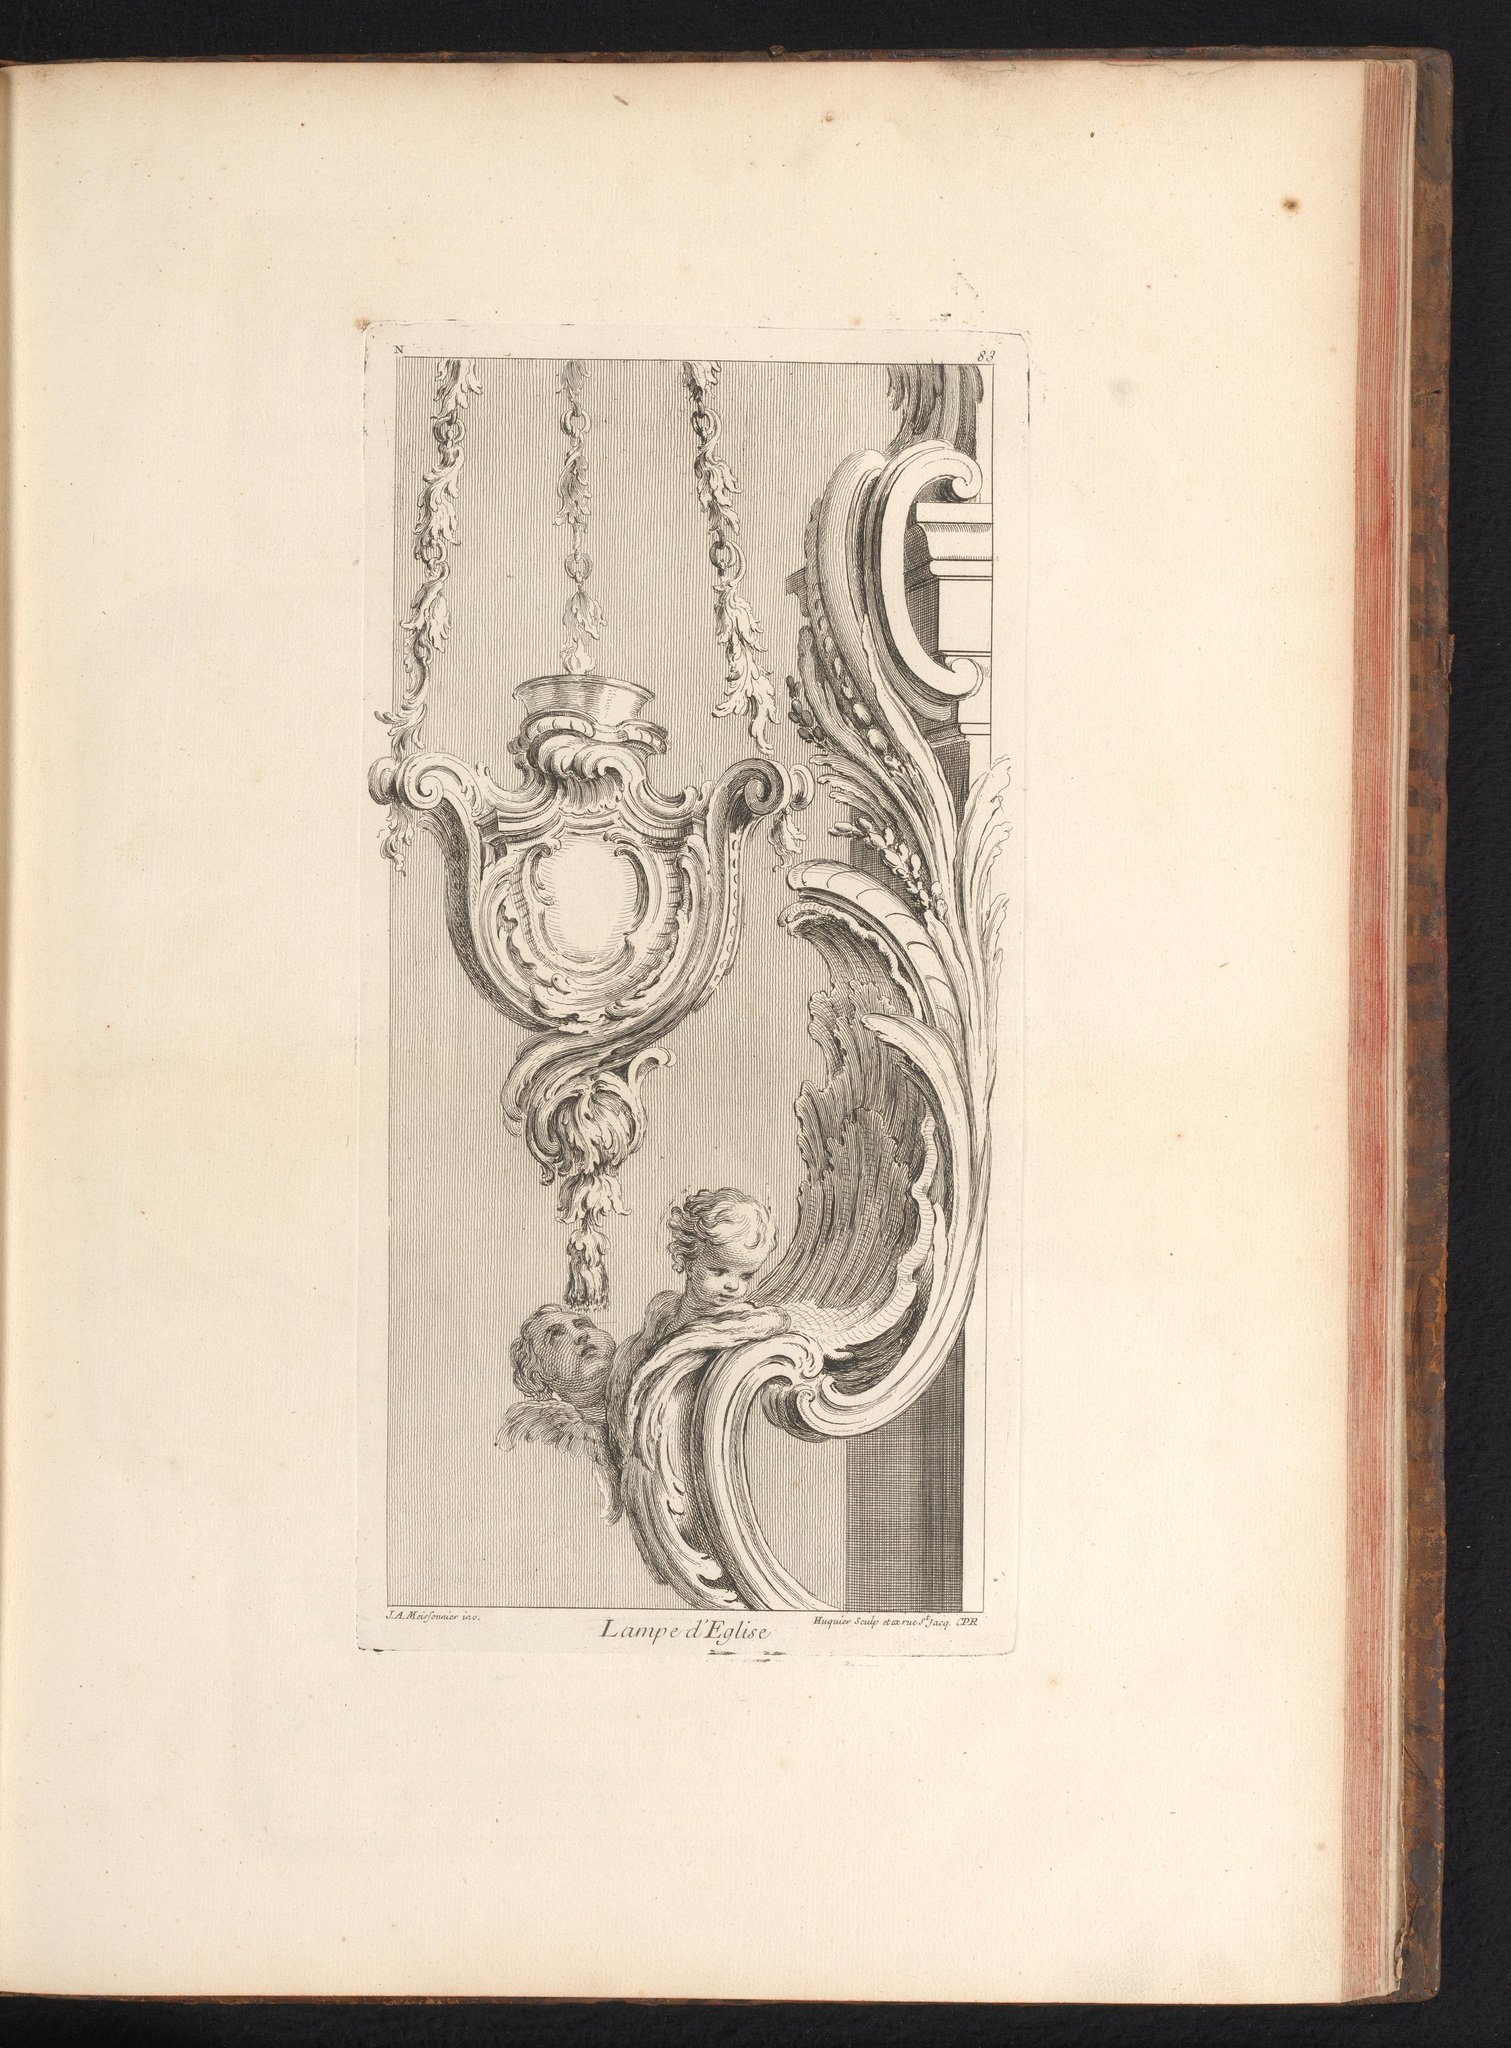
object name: ornament print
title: Lampe d'eglise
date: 1738-1749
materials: paper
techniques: etching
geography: paris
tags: other objects ~ the church (not necessarily liturgical, oil-lamp, work of applied art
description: Deze prent maakt deel uit van de serie "Treisieme livre des oeuvres de J.A. Meissonnier", een van de delen van de monumentale reeks "Oeuvre de Juste Aurele Meissonnier".